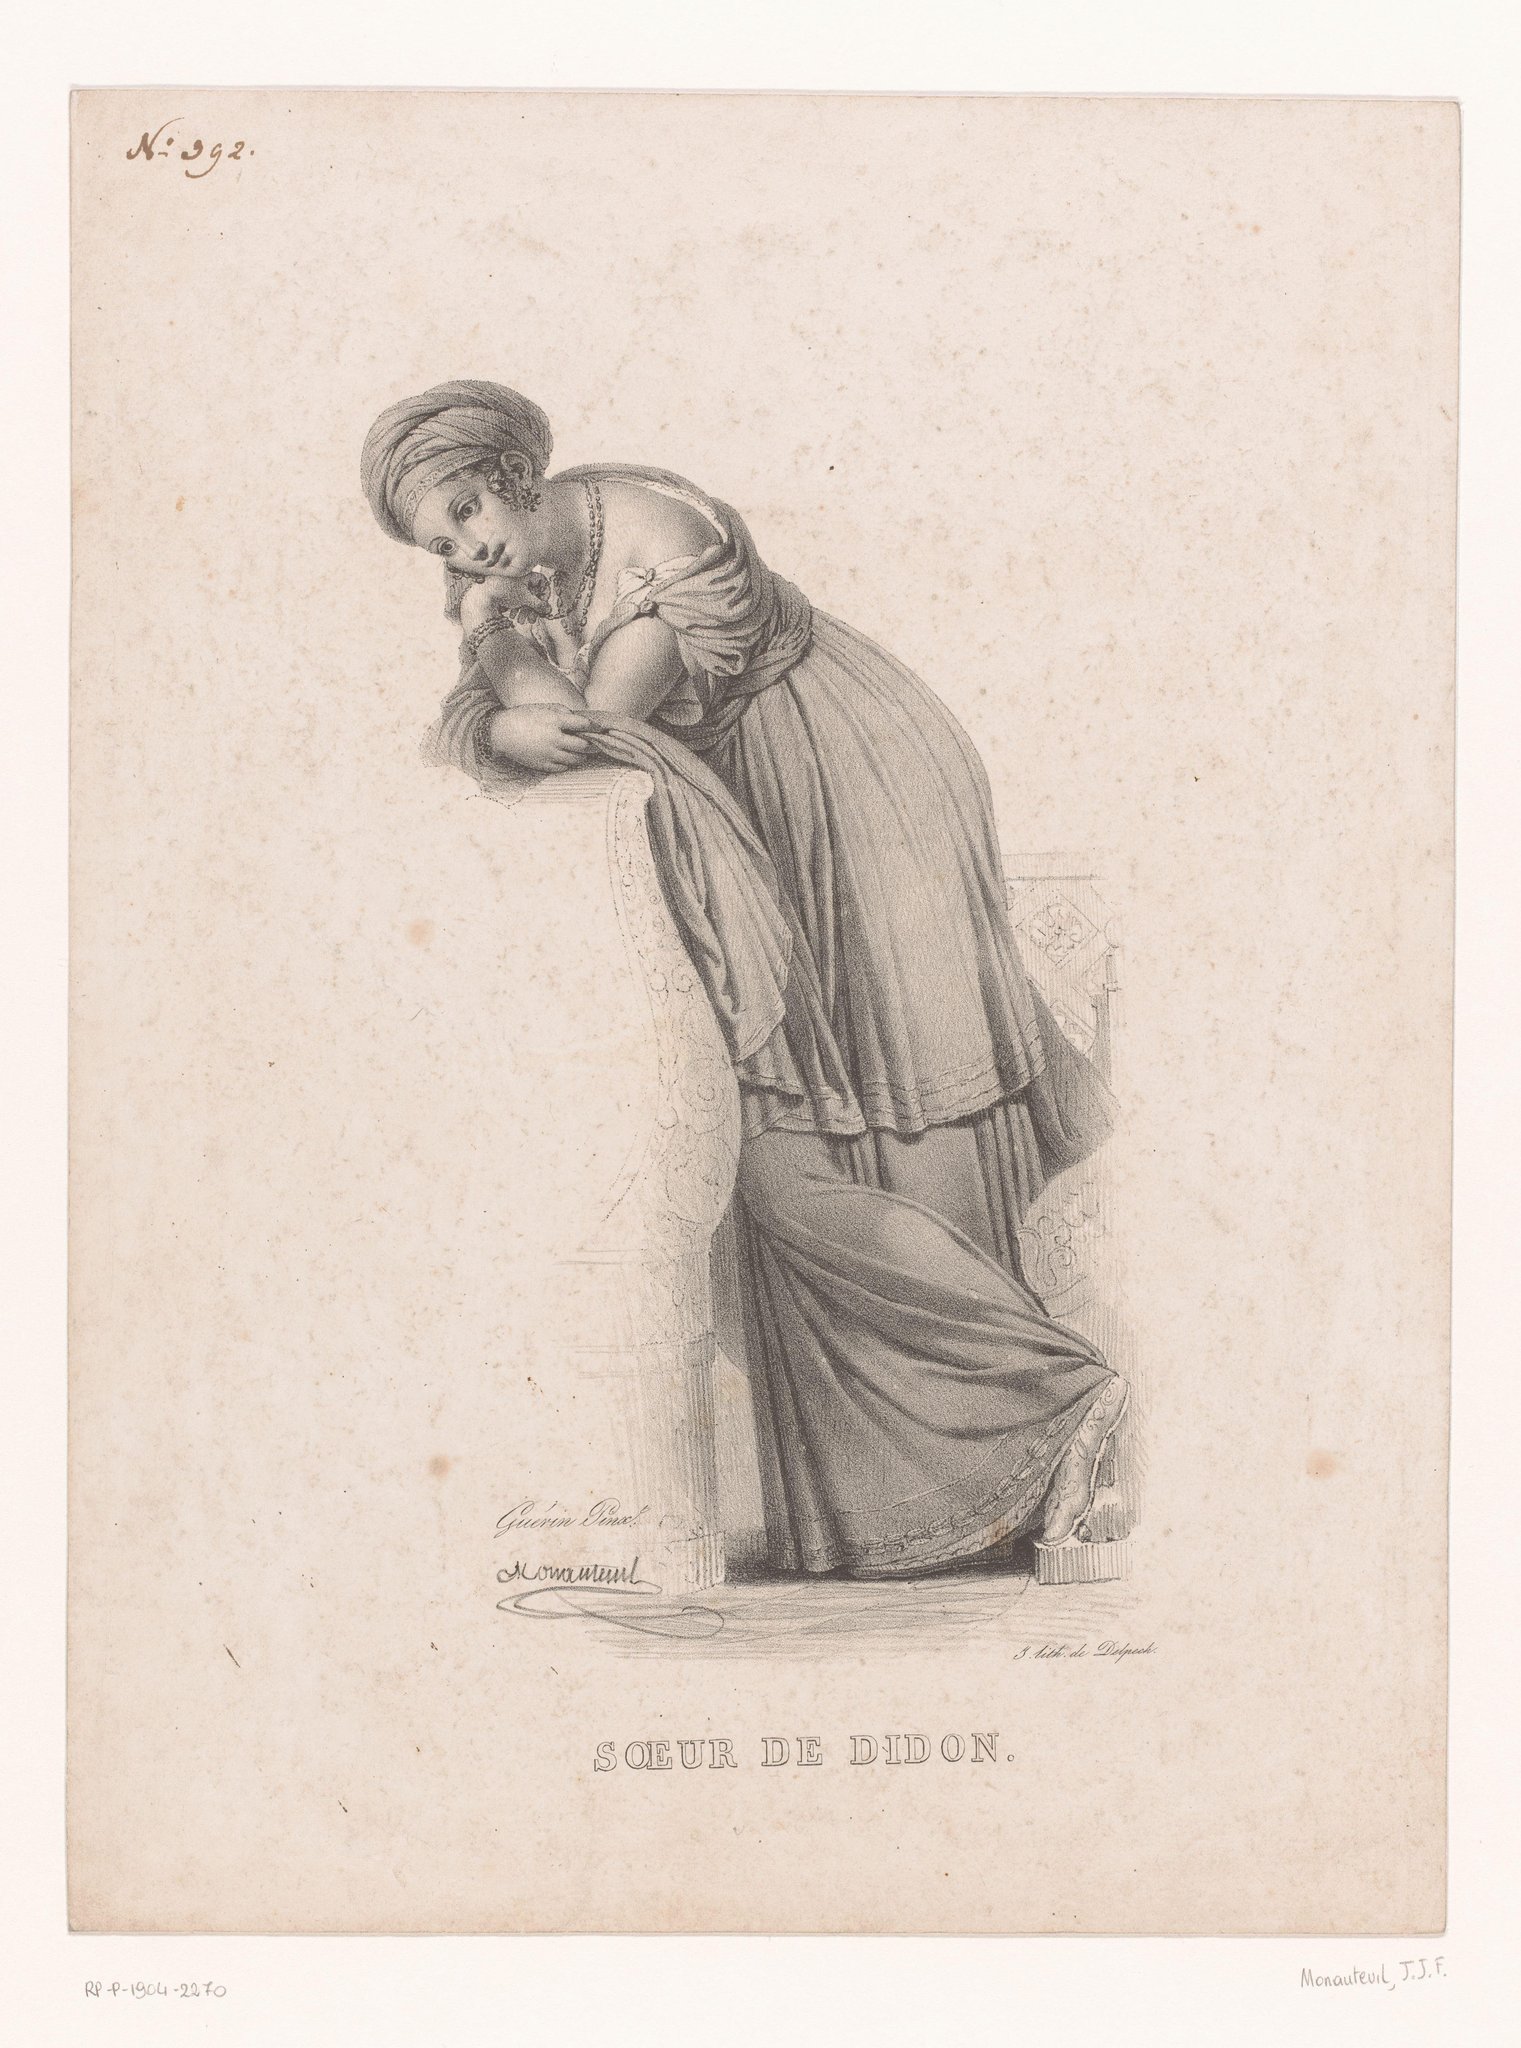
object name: print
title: Portret van Anna, de zuster van Dido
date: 1818-1842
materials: paper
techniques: lithograph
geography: paris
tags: (story of) anna, dido's sister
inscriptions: collector's mark: Lugt 2228, inscription: ‘No. 392.’